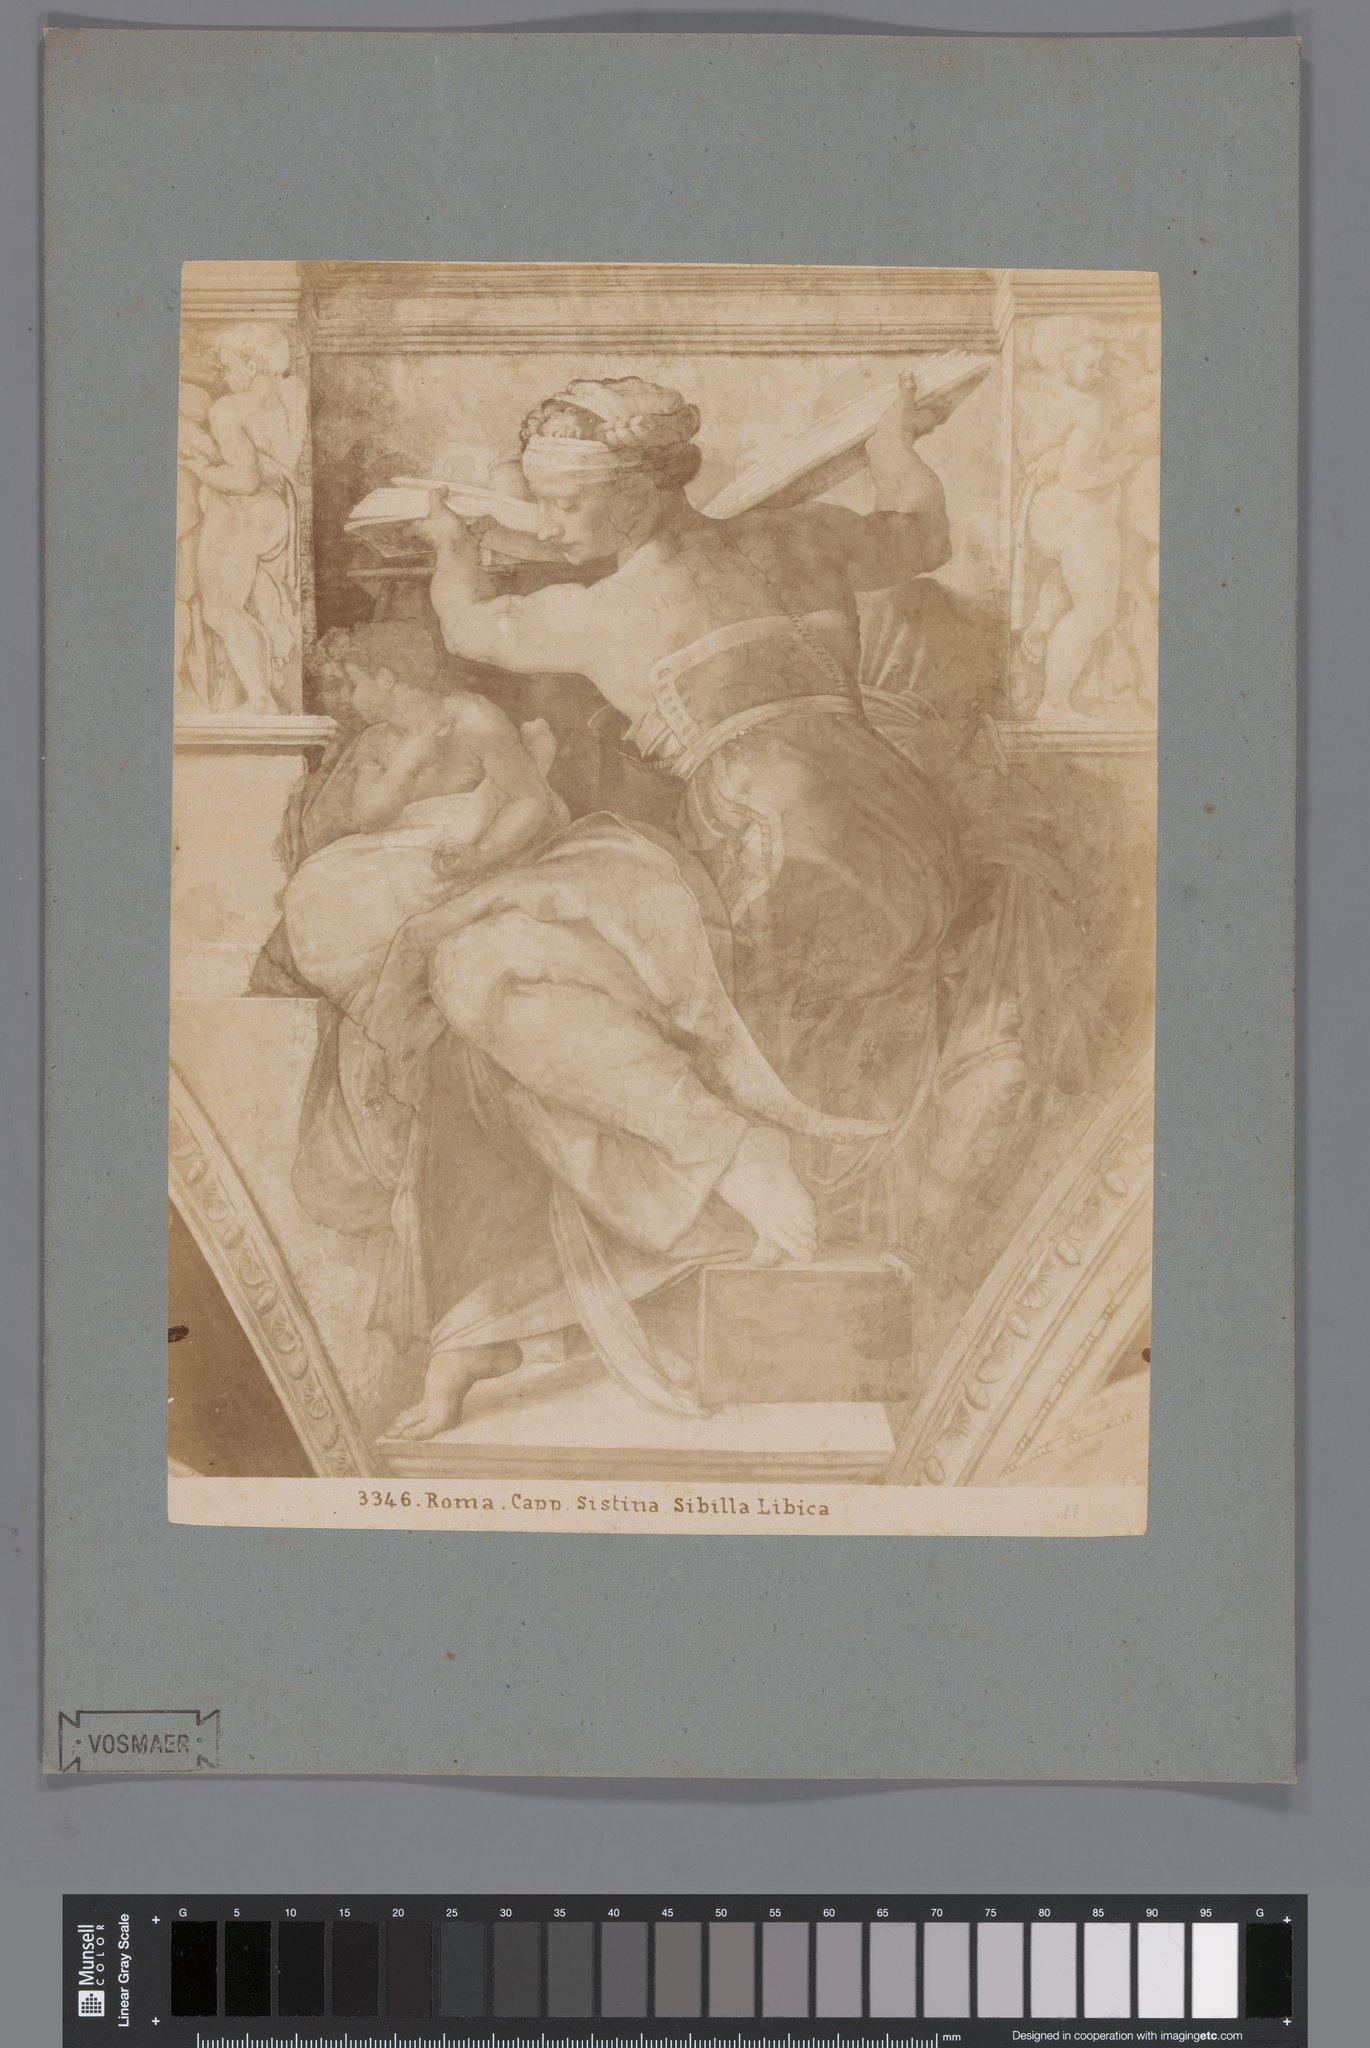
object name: photograph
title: Fotoreproductie van het fresco De Libische Sibille door Michelangelo in de Sixtijnse kapel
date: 1851-1900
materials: cardboard, paper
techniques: albumen print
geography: vatican city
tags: sibyls (with name), picture, painting, wall-covering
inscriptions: number: ‘3346.’, inscription: ‘doubl.’, collector's mark: ‘VOSMAER’